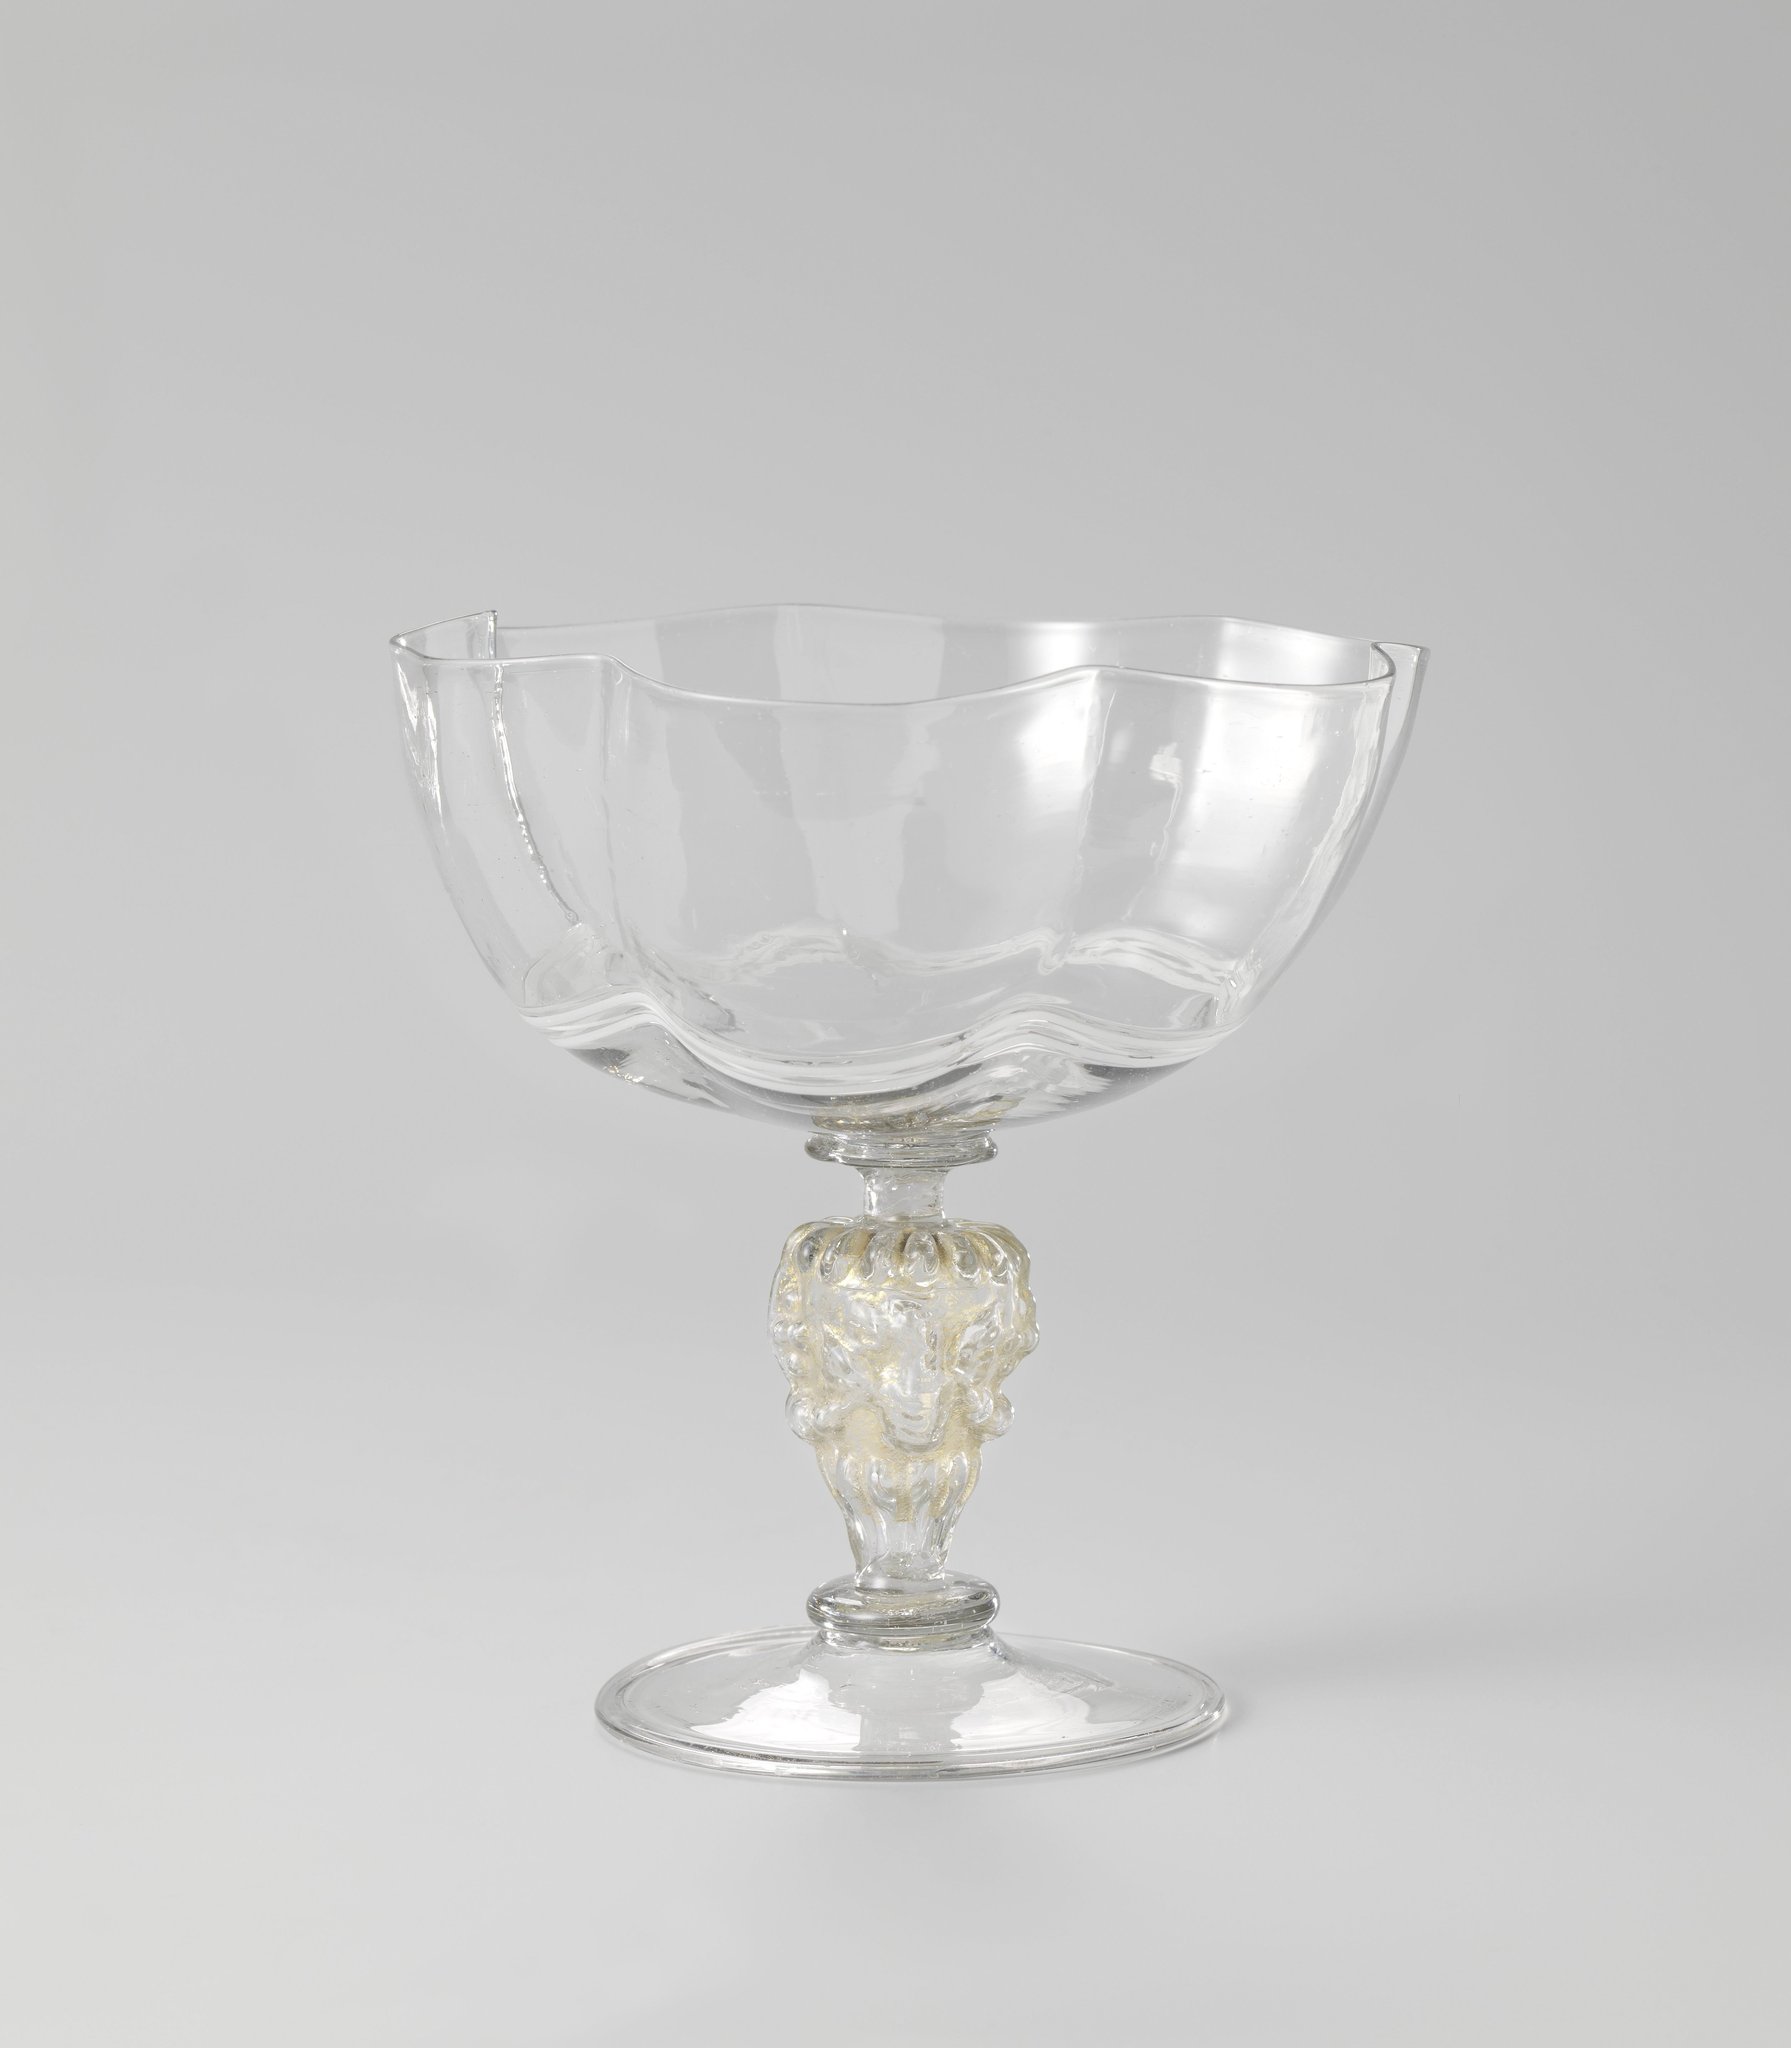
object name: goblet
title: Kelkglas met zeslobbige kelk met lattimo draden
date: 1550-1600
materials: glass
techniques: façon de venise, filigree glass, glassblowing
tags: mask, mascaron ~ ornament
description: Platte voet met omgeslagen rand. Holle, balustervormige stam, in de vorm geblazen met twee vogelachtige wezens onder een knorrenrand. Zeslobbige kelk, aan de onderzijde versierd met een band lattimo draden.